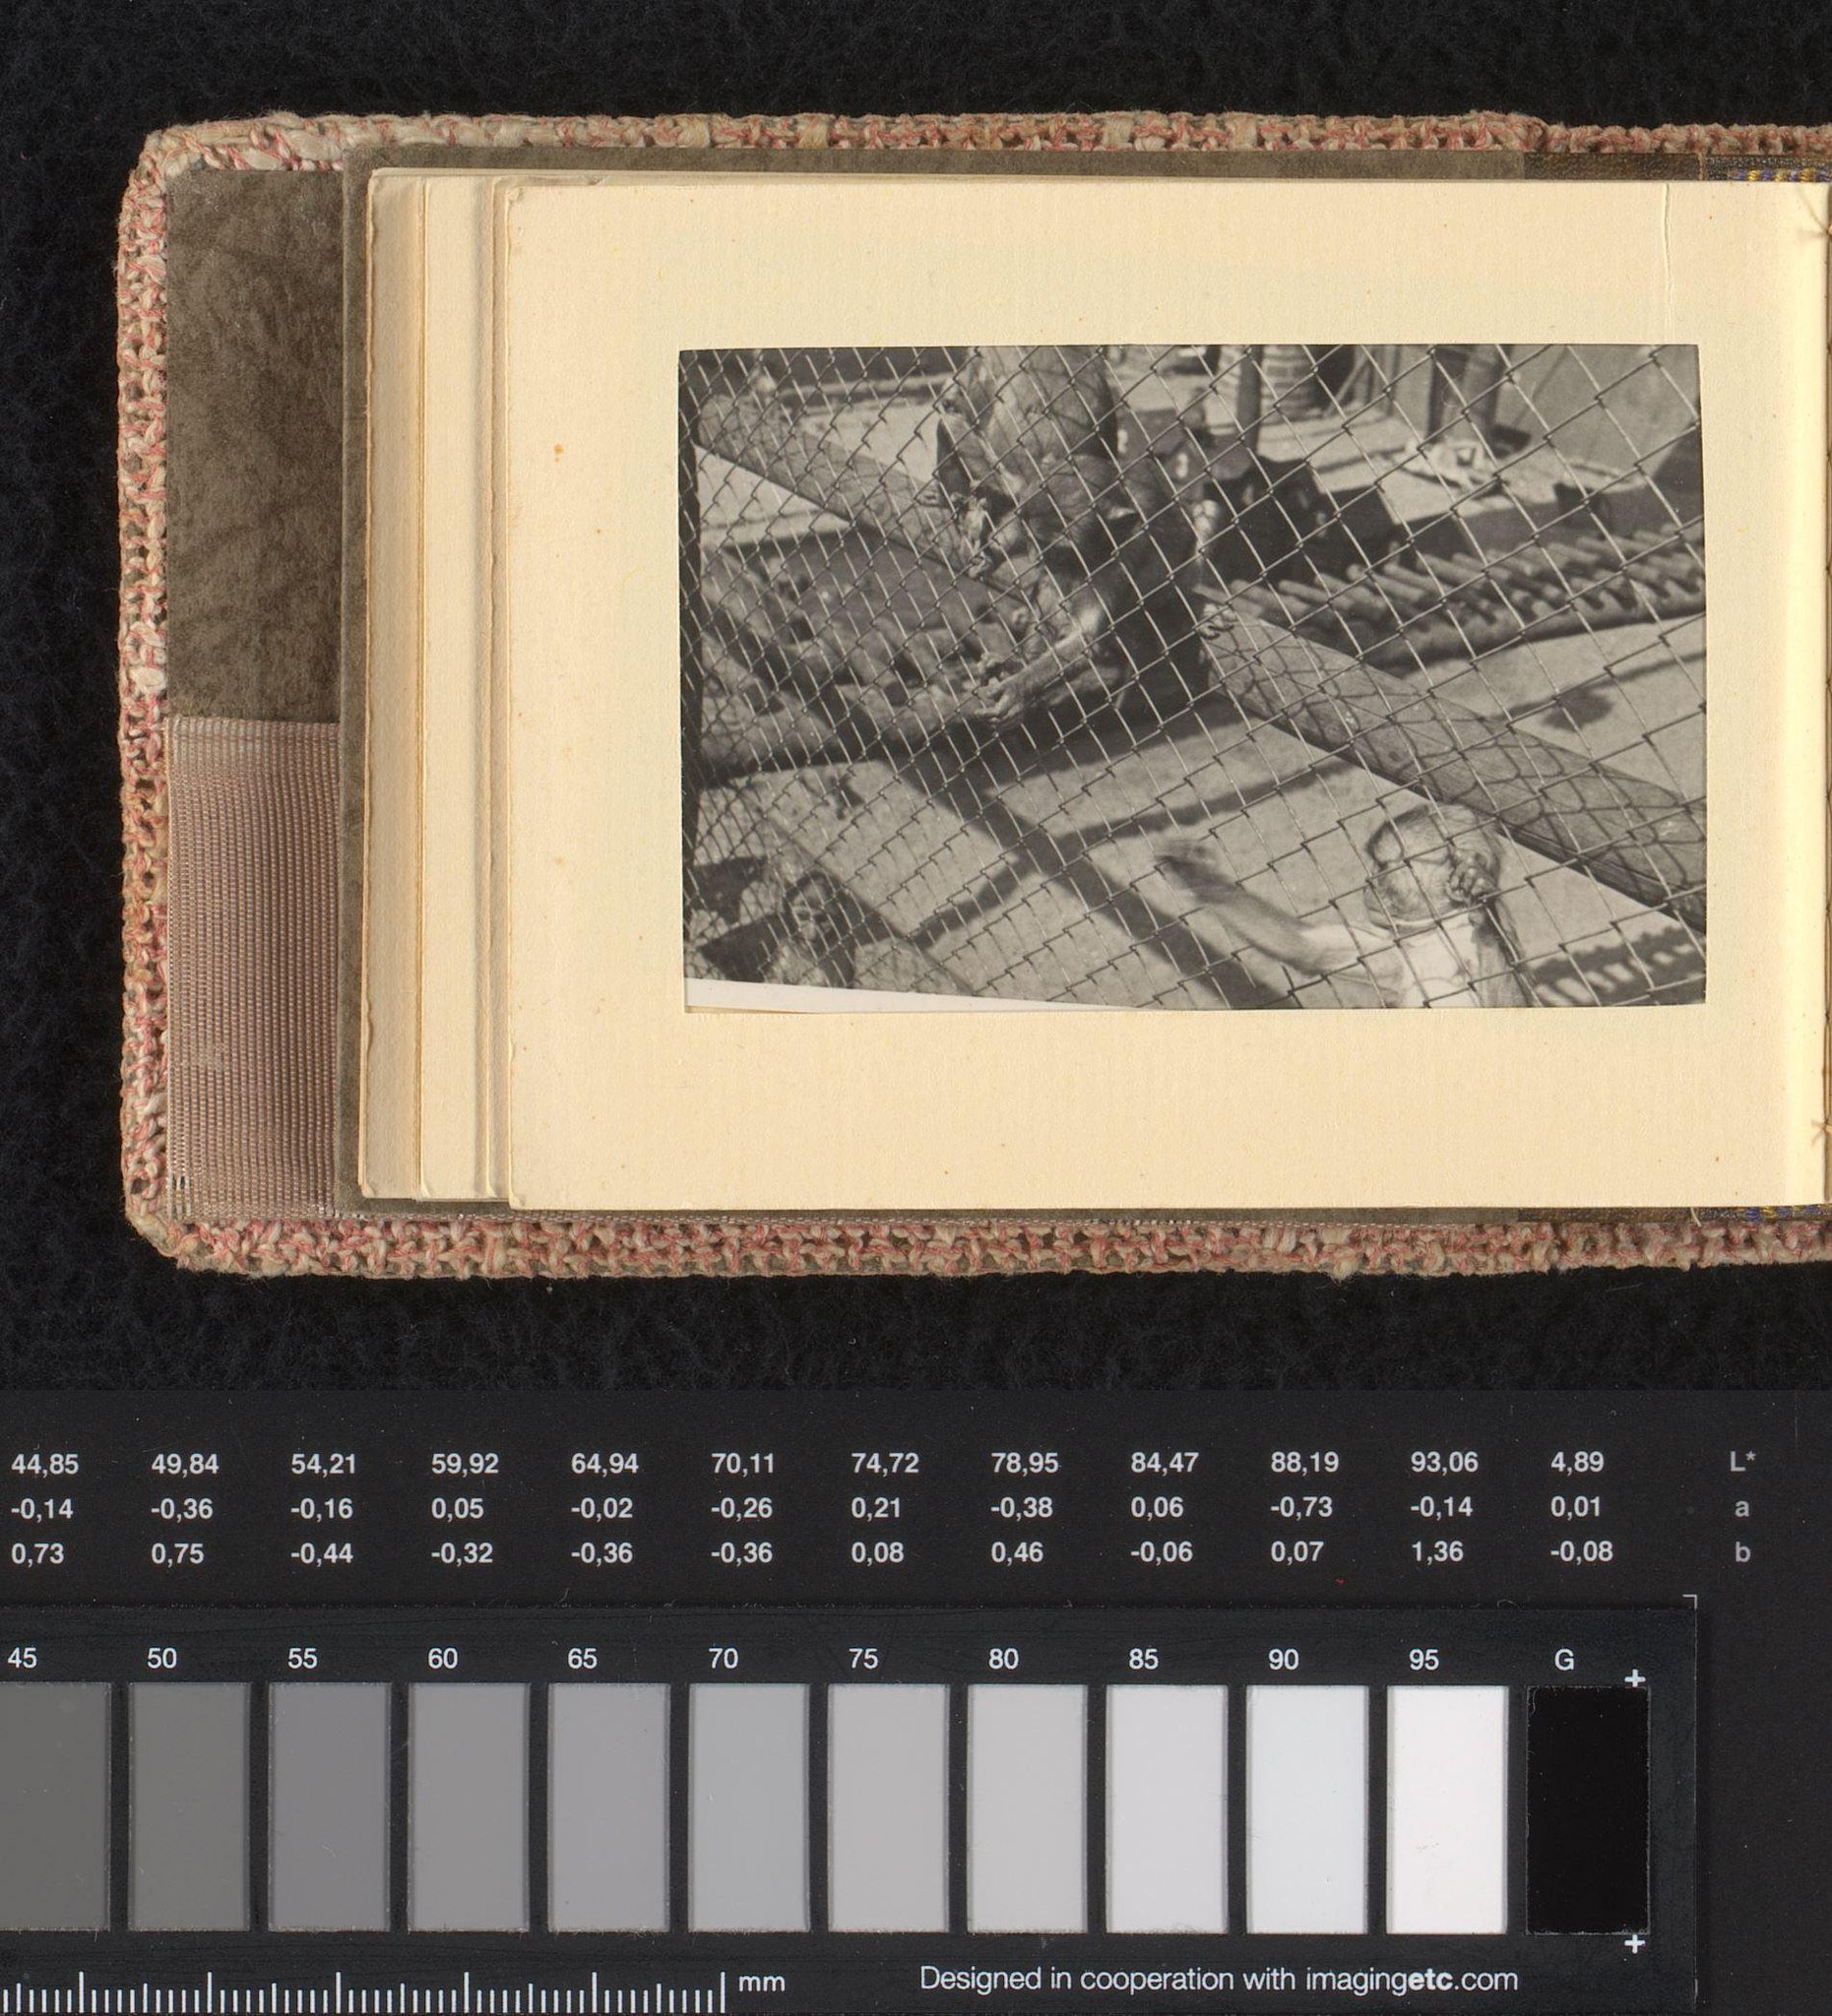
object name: photograph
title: Apen in de dierentuin, juli-augustus 1933, Hamburg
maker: else wachenheimer-moos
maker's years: 1895-1944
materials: paper, photographic support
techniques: gelatin silver print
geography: hamburg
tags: the family travelling, on holiday, monkeys, apes, zoo (as place of recreation)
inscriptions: date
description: Albumblad bevat een foto. Onderdeel van het fotoalbum Hamburg zomer 1933.